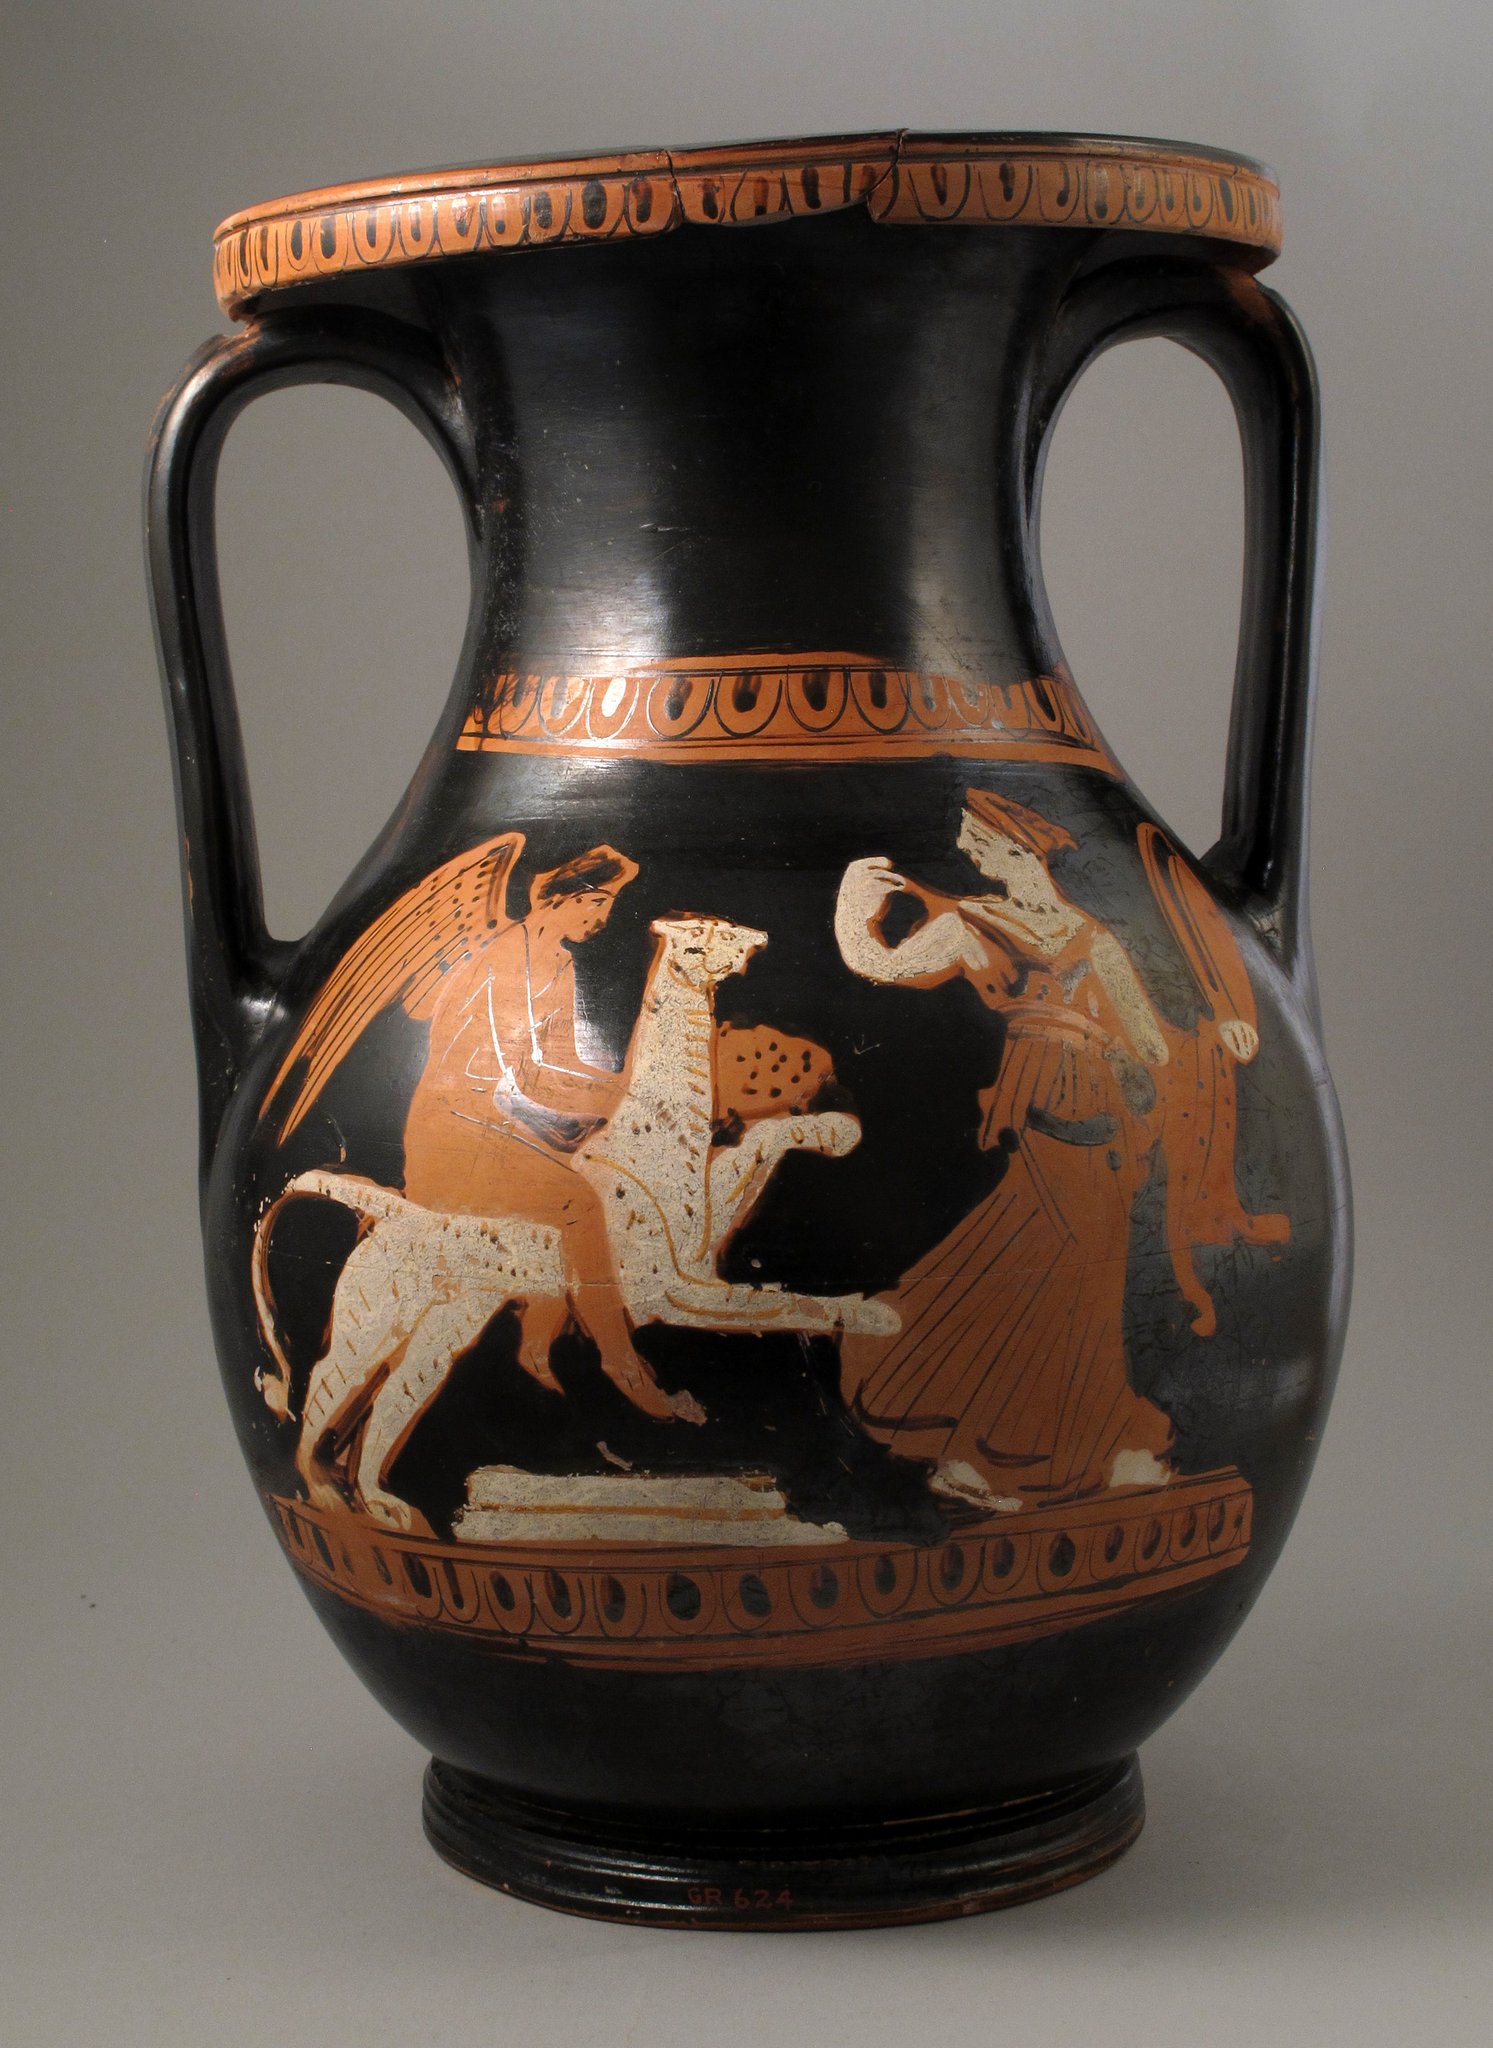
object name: pelike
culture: greek, attic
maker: black thyrsus painter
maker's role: artist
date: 400 BCE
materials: terracotta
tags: animals,eros,maenads,panthers